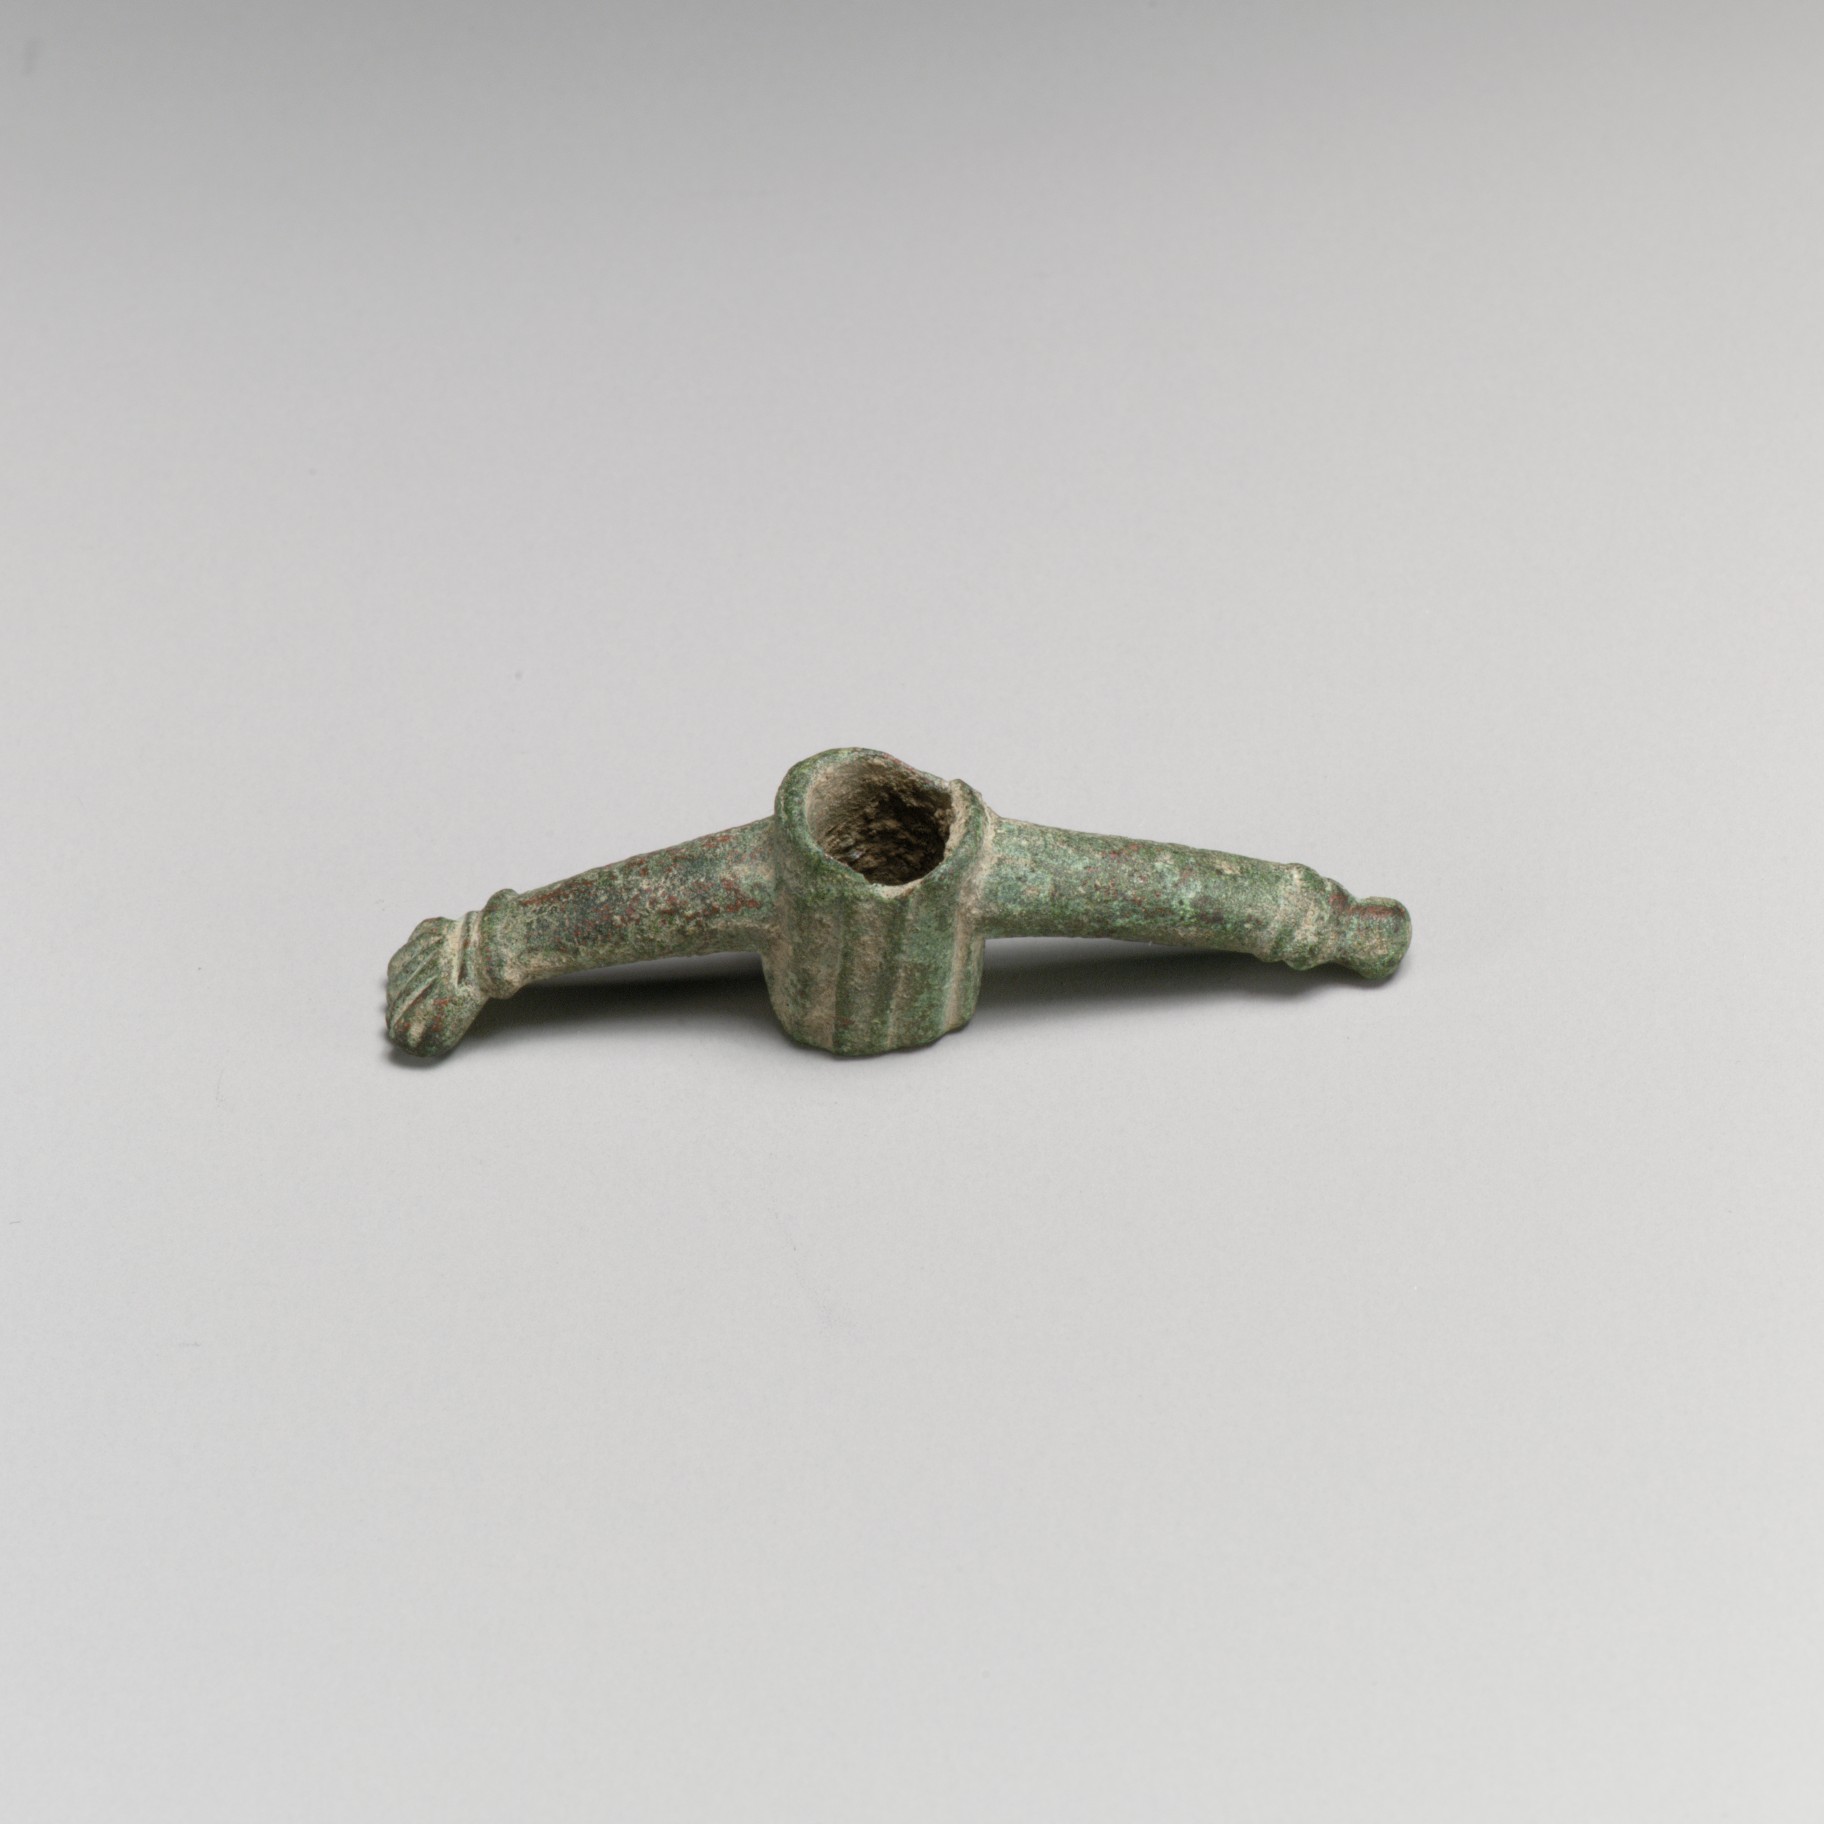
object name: amulet, grotesque ornament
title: Bronze phallic amulet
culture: roman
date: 1-100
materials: bronze